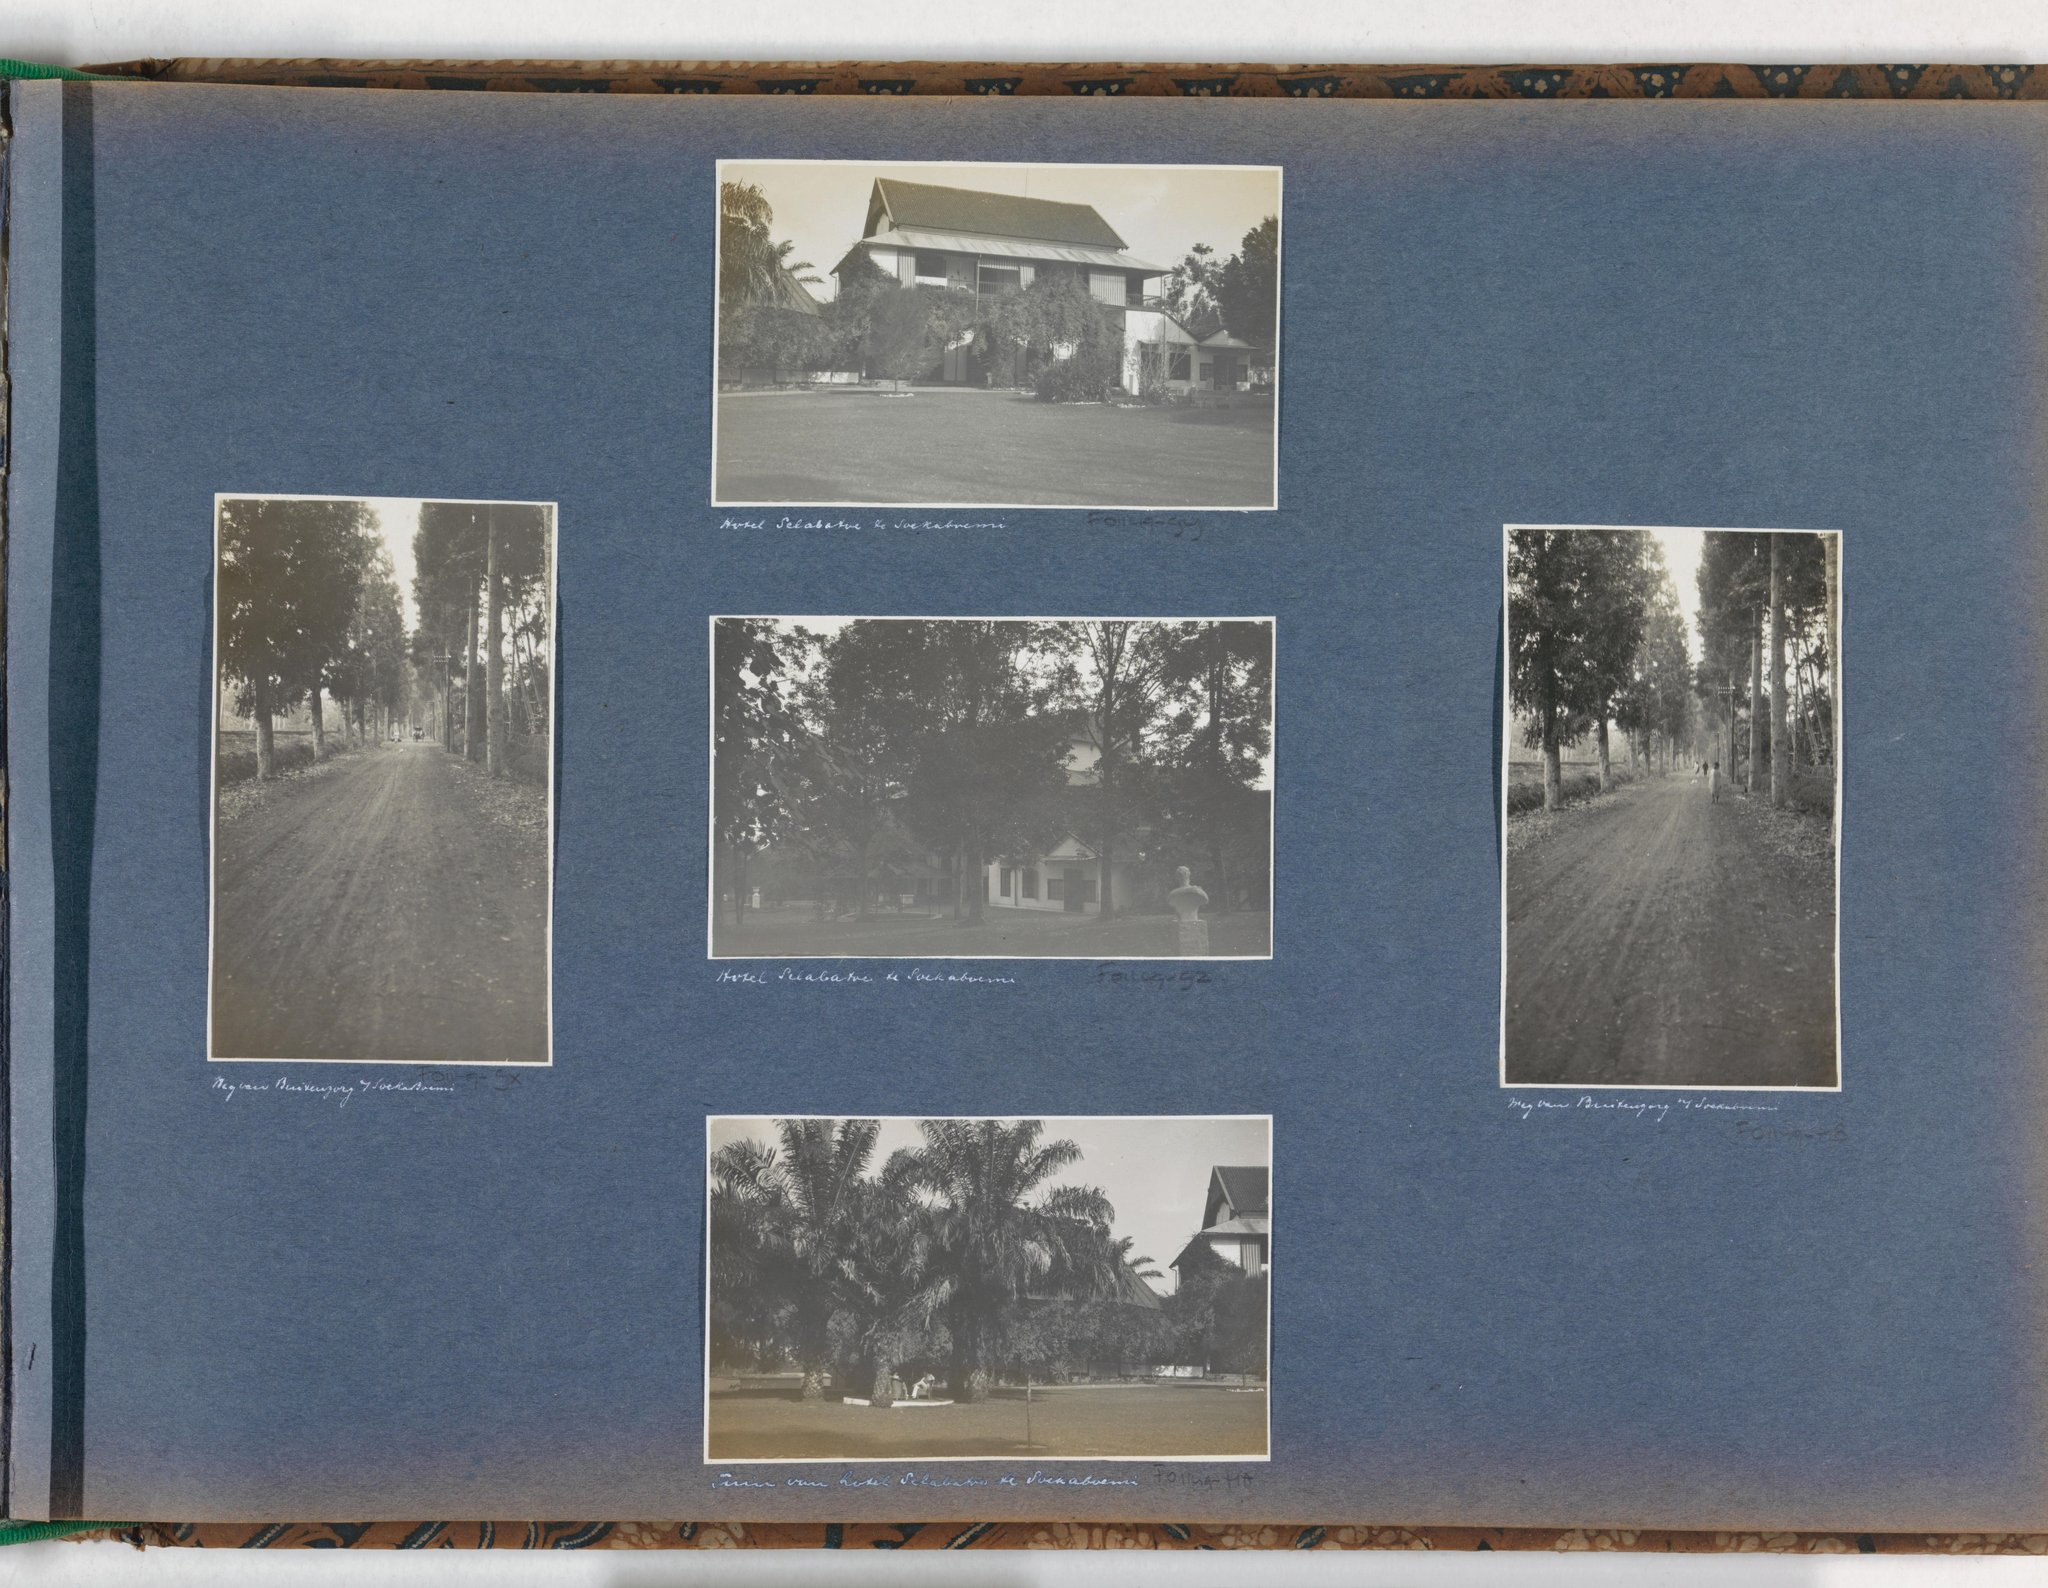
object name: photograph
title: Weg van Buitenzorg naar Soekaboemi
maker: Anonymous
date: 1900-1920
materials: paper, photographic support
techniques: gelatin silver print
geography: java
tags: forest path or lane, java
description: Onderdeel van reisalbum met foto's van bedrijvigheid en bezienswaardigheden op Sumatra en Java en van de reis naar en van Nederlands-Indië.